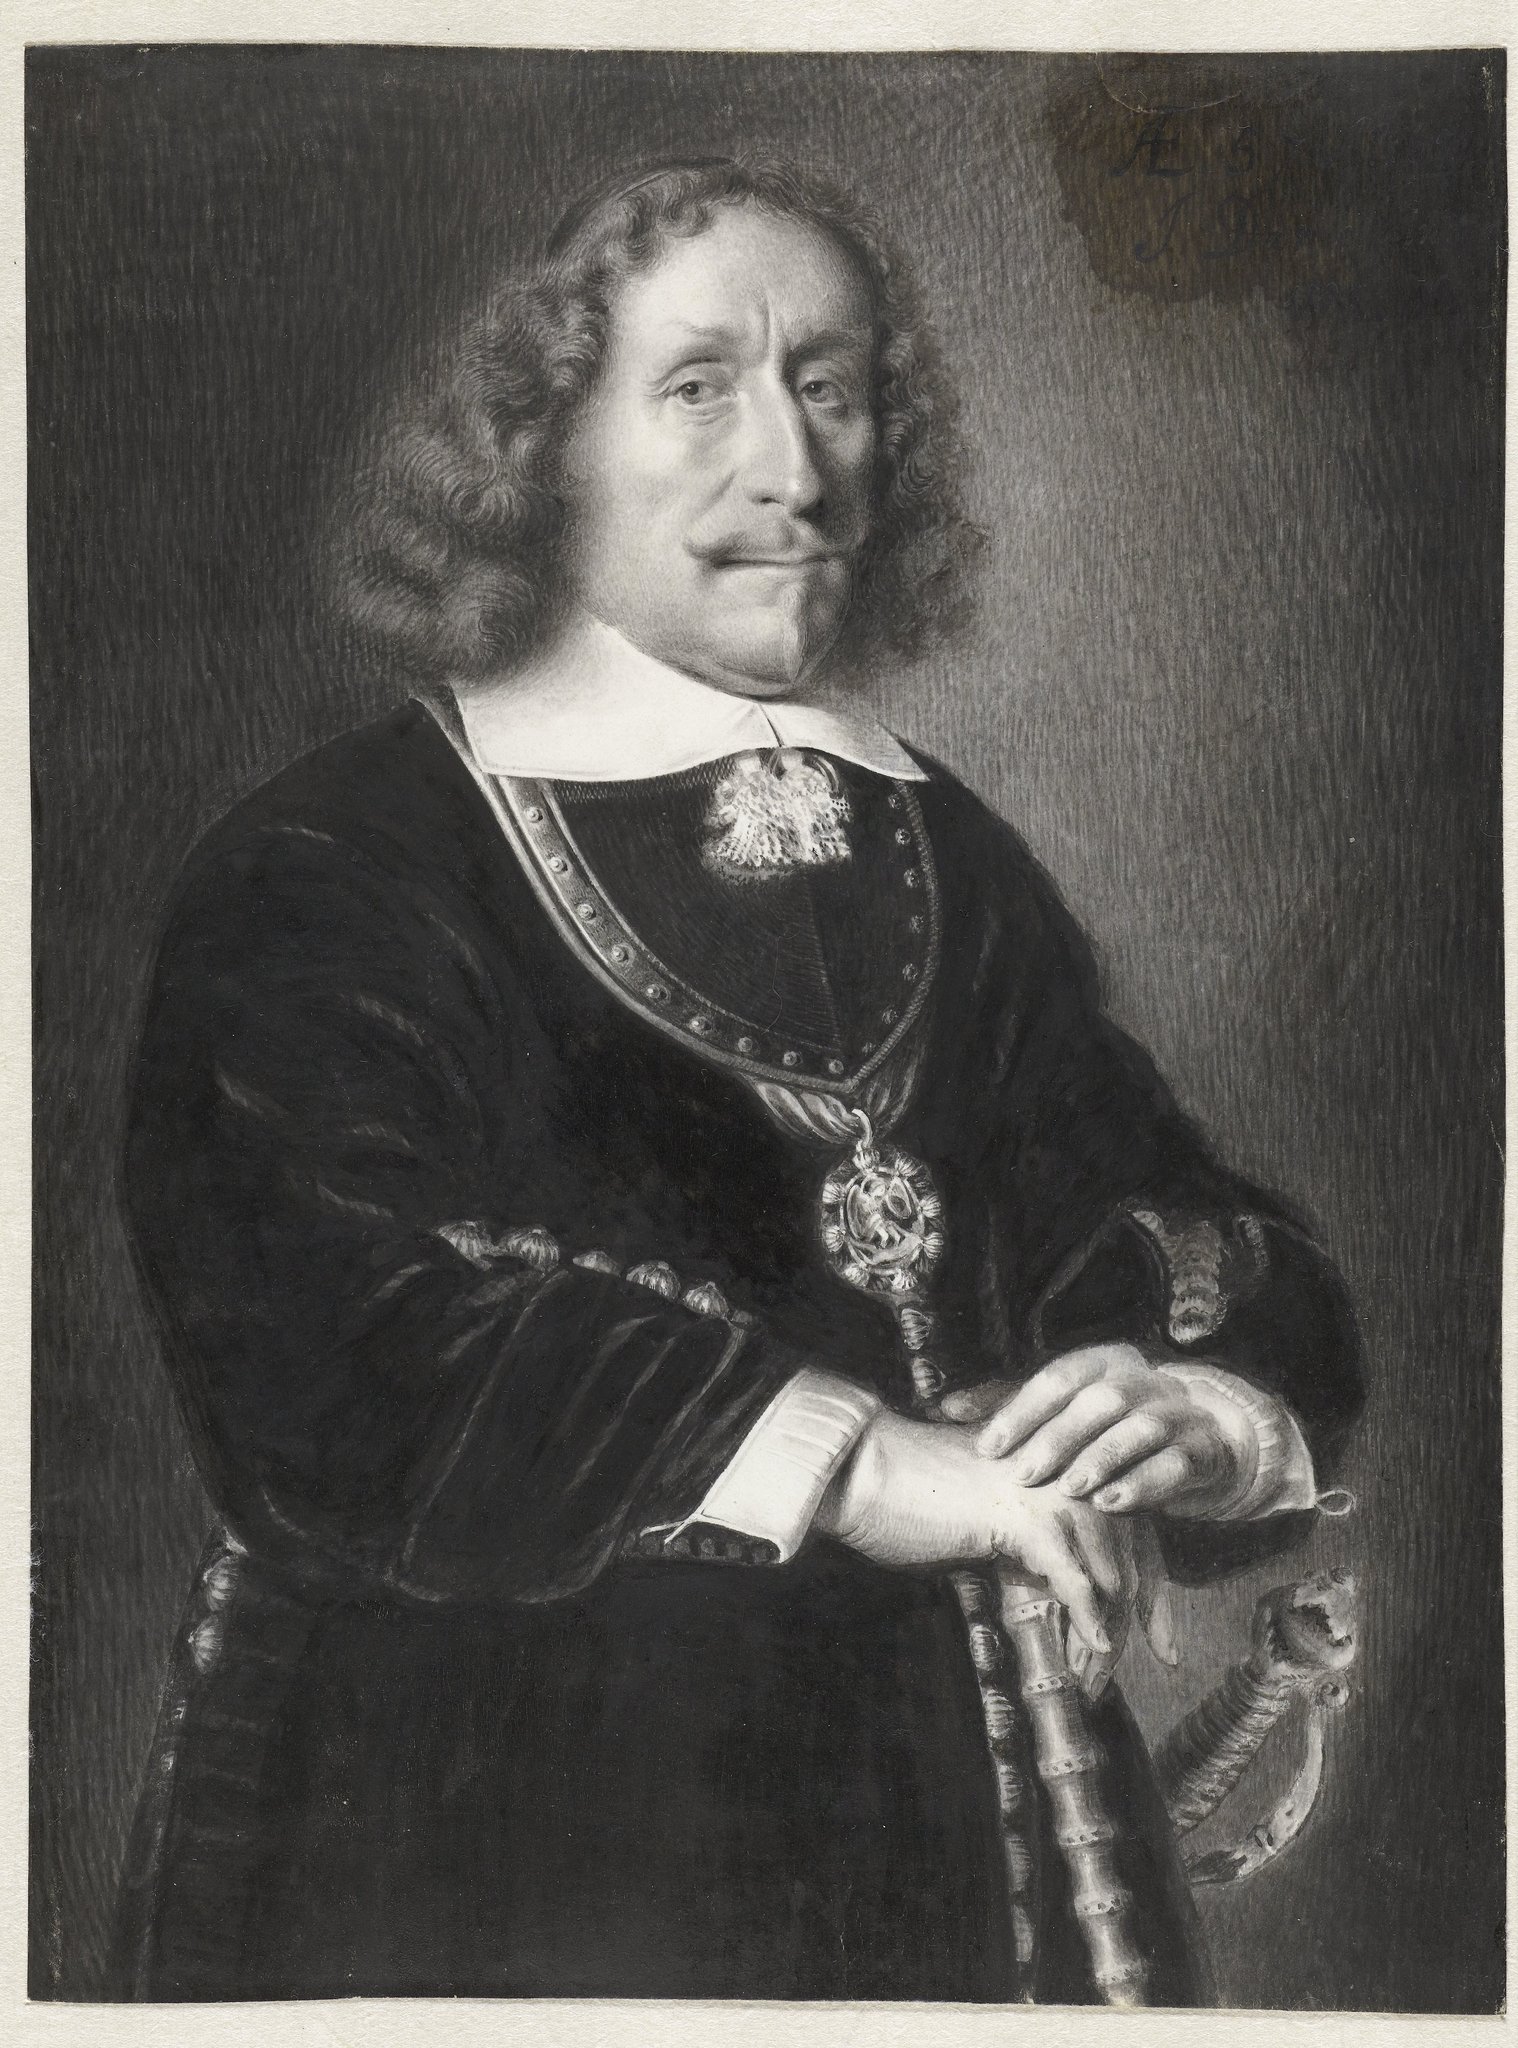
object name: drawing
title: Portret van vlootvoogd Witte Cornelisz. de With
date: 1680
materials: parchment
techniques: brush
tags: historical persons, commander-in-chief, admiral